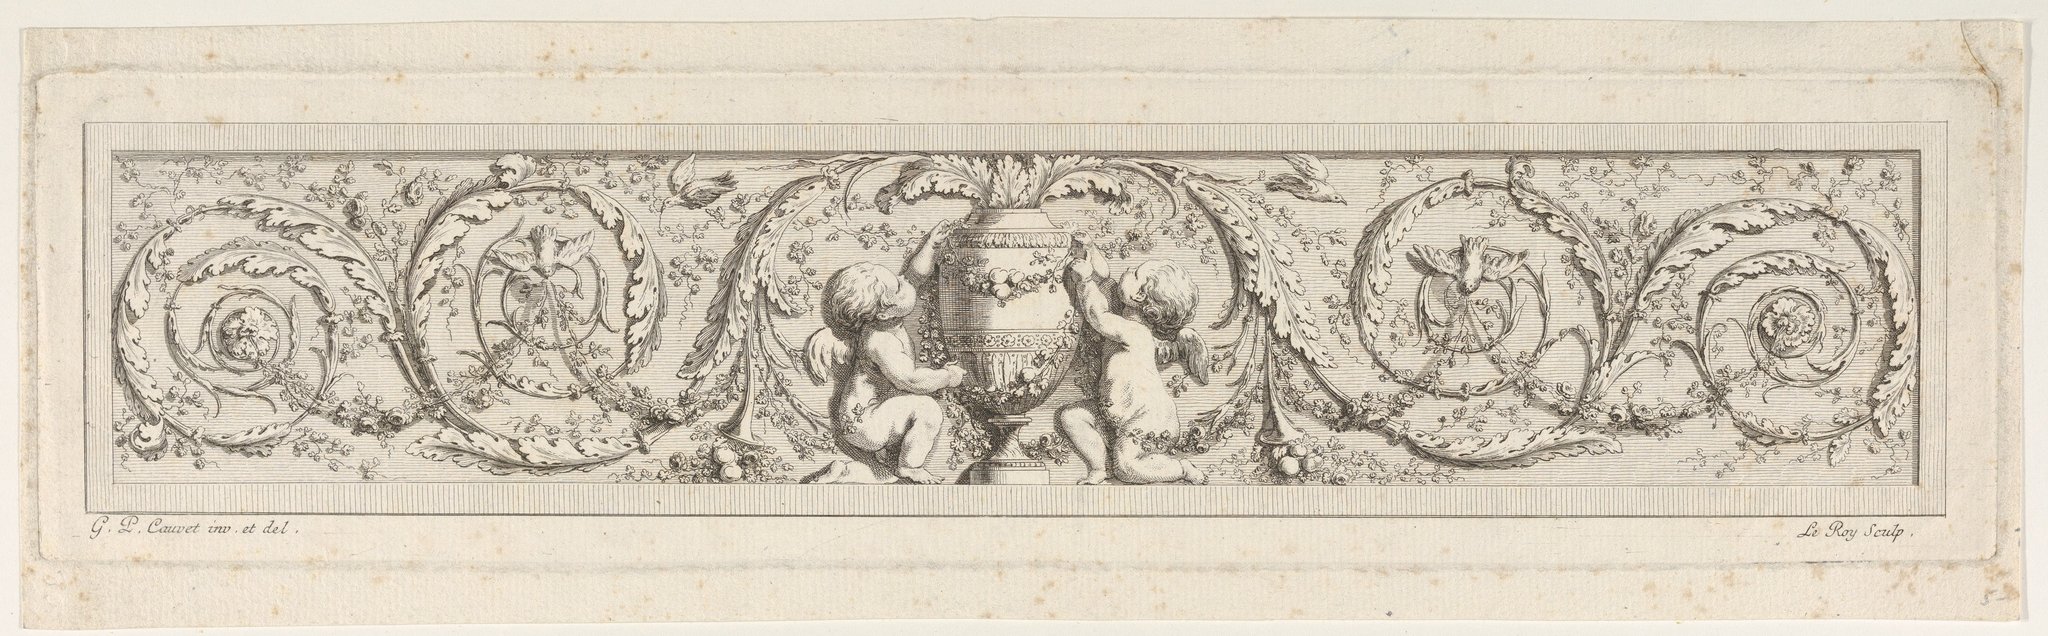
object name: print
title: Design for a Frieze with Acanthus Scrolls and a Vase with Two Putti in the Center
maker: le roy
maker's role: etcher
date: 1777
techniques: etching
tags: birds,putti,acanthus